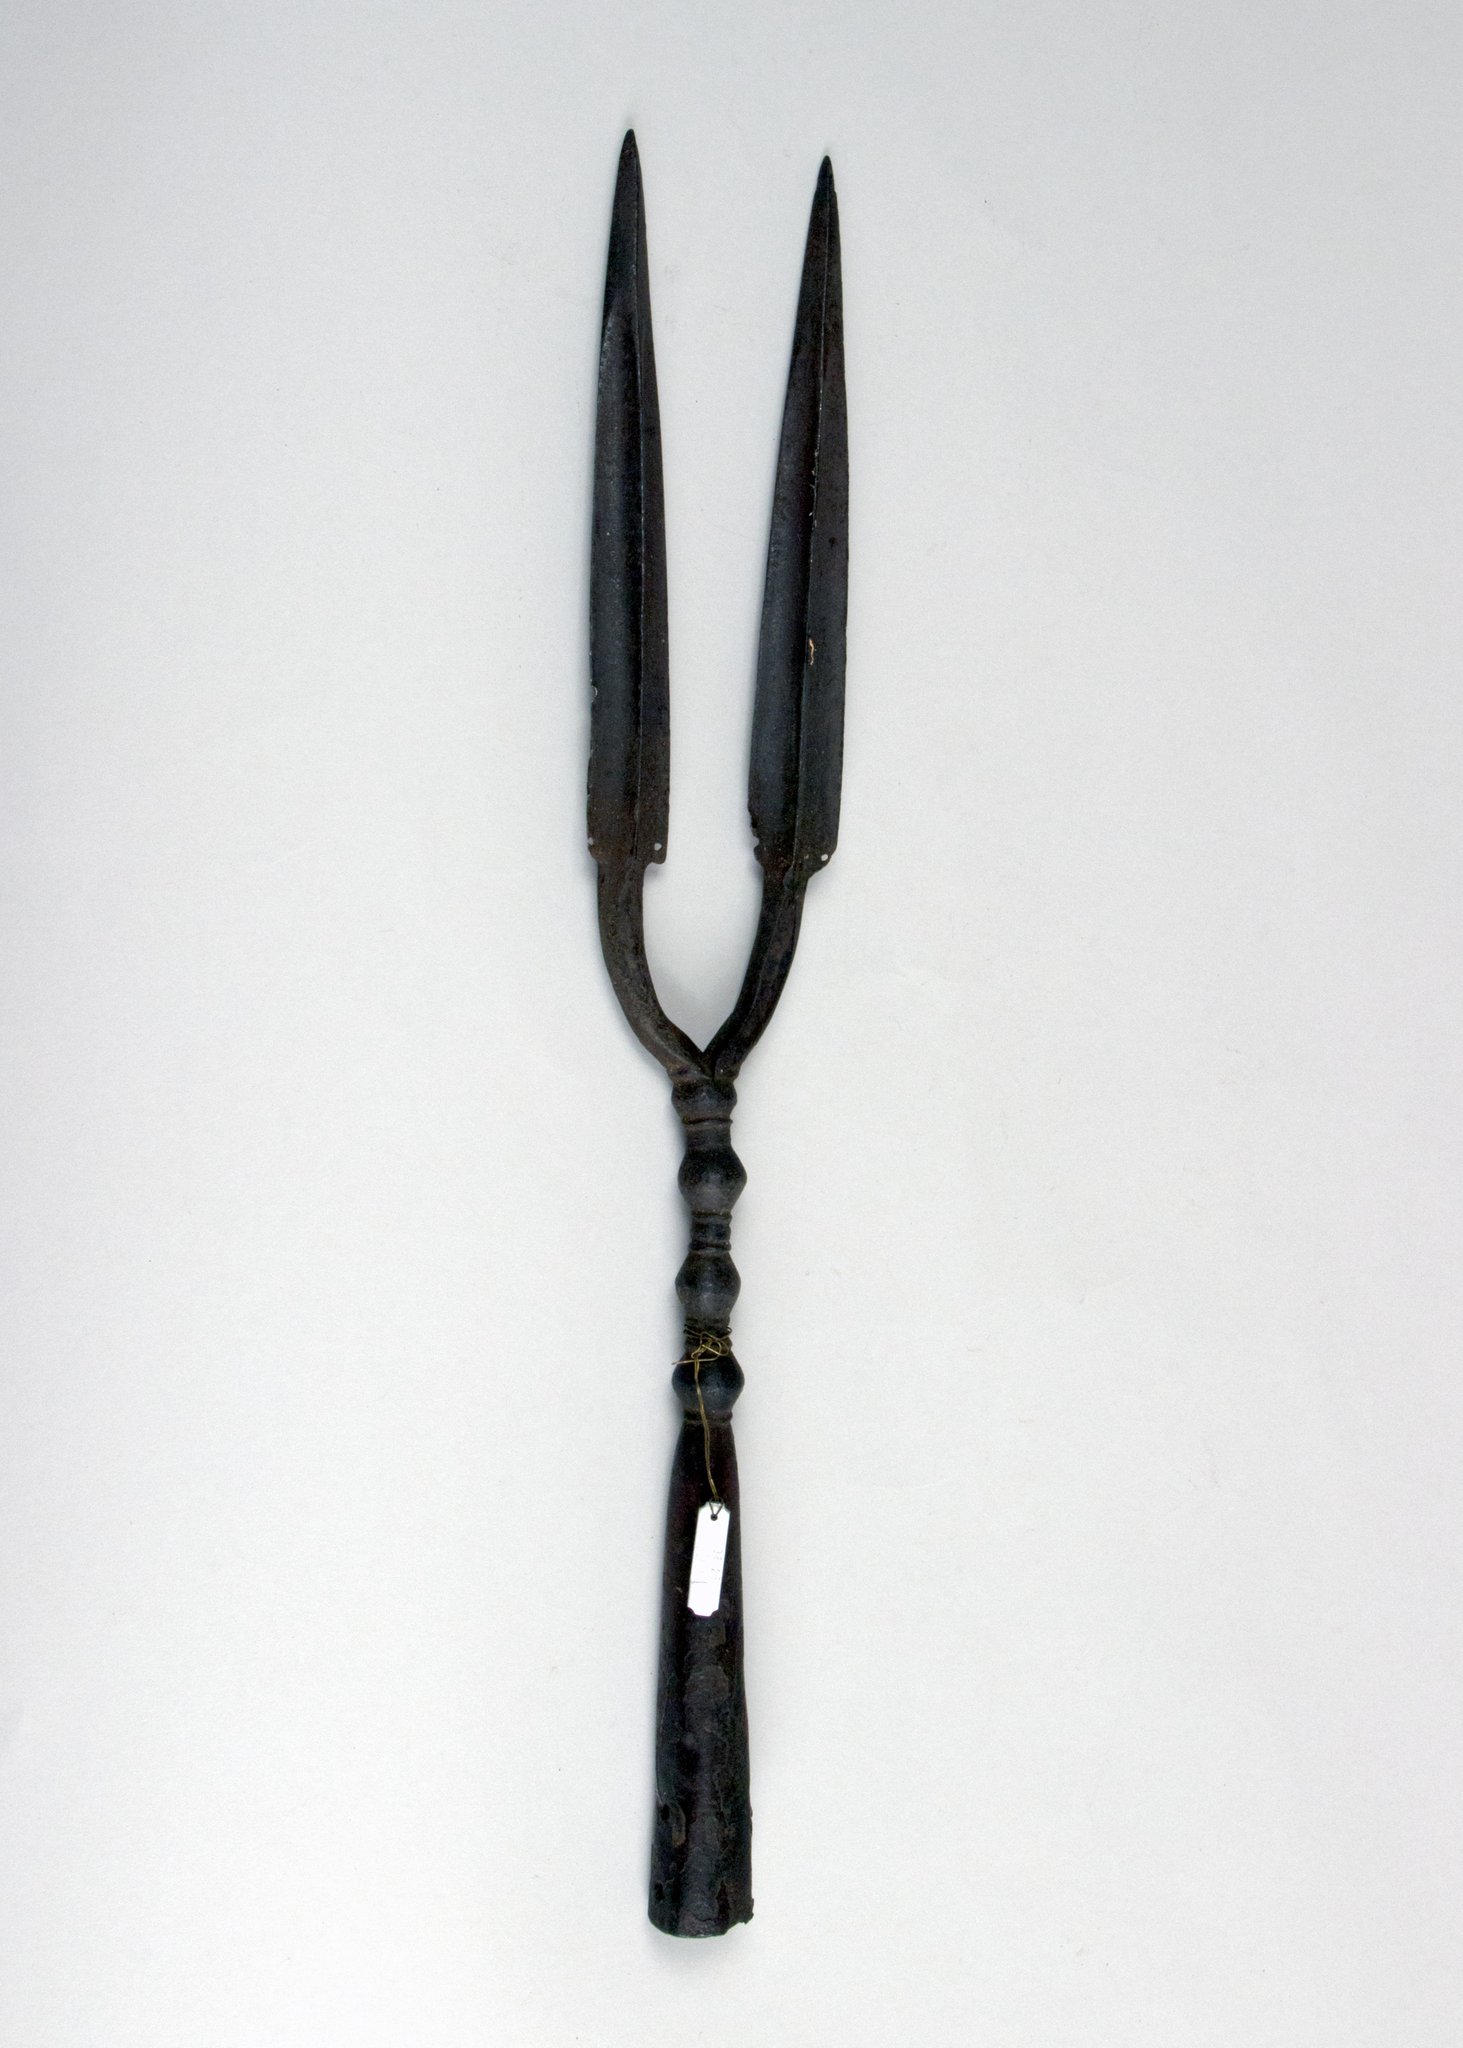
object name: bident head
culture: turkish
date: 1801-1900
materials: steel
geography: ottoman empire